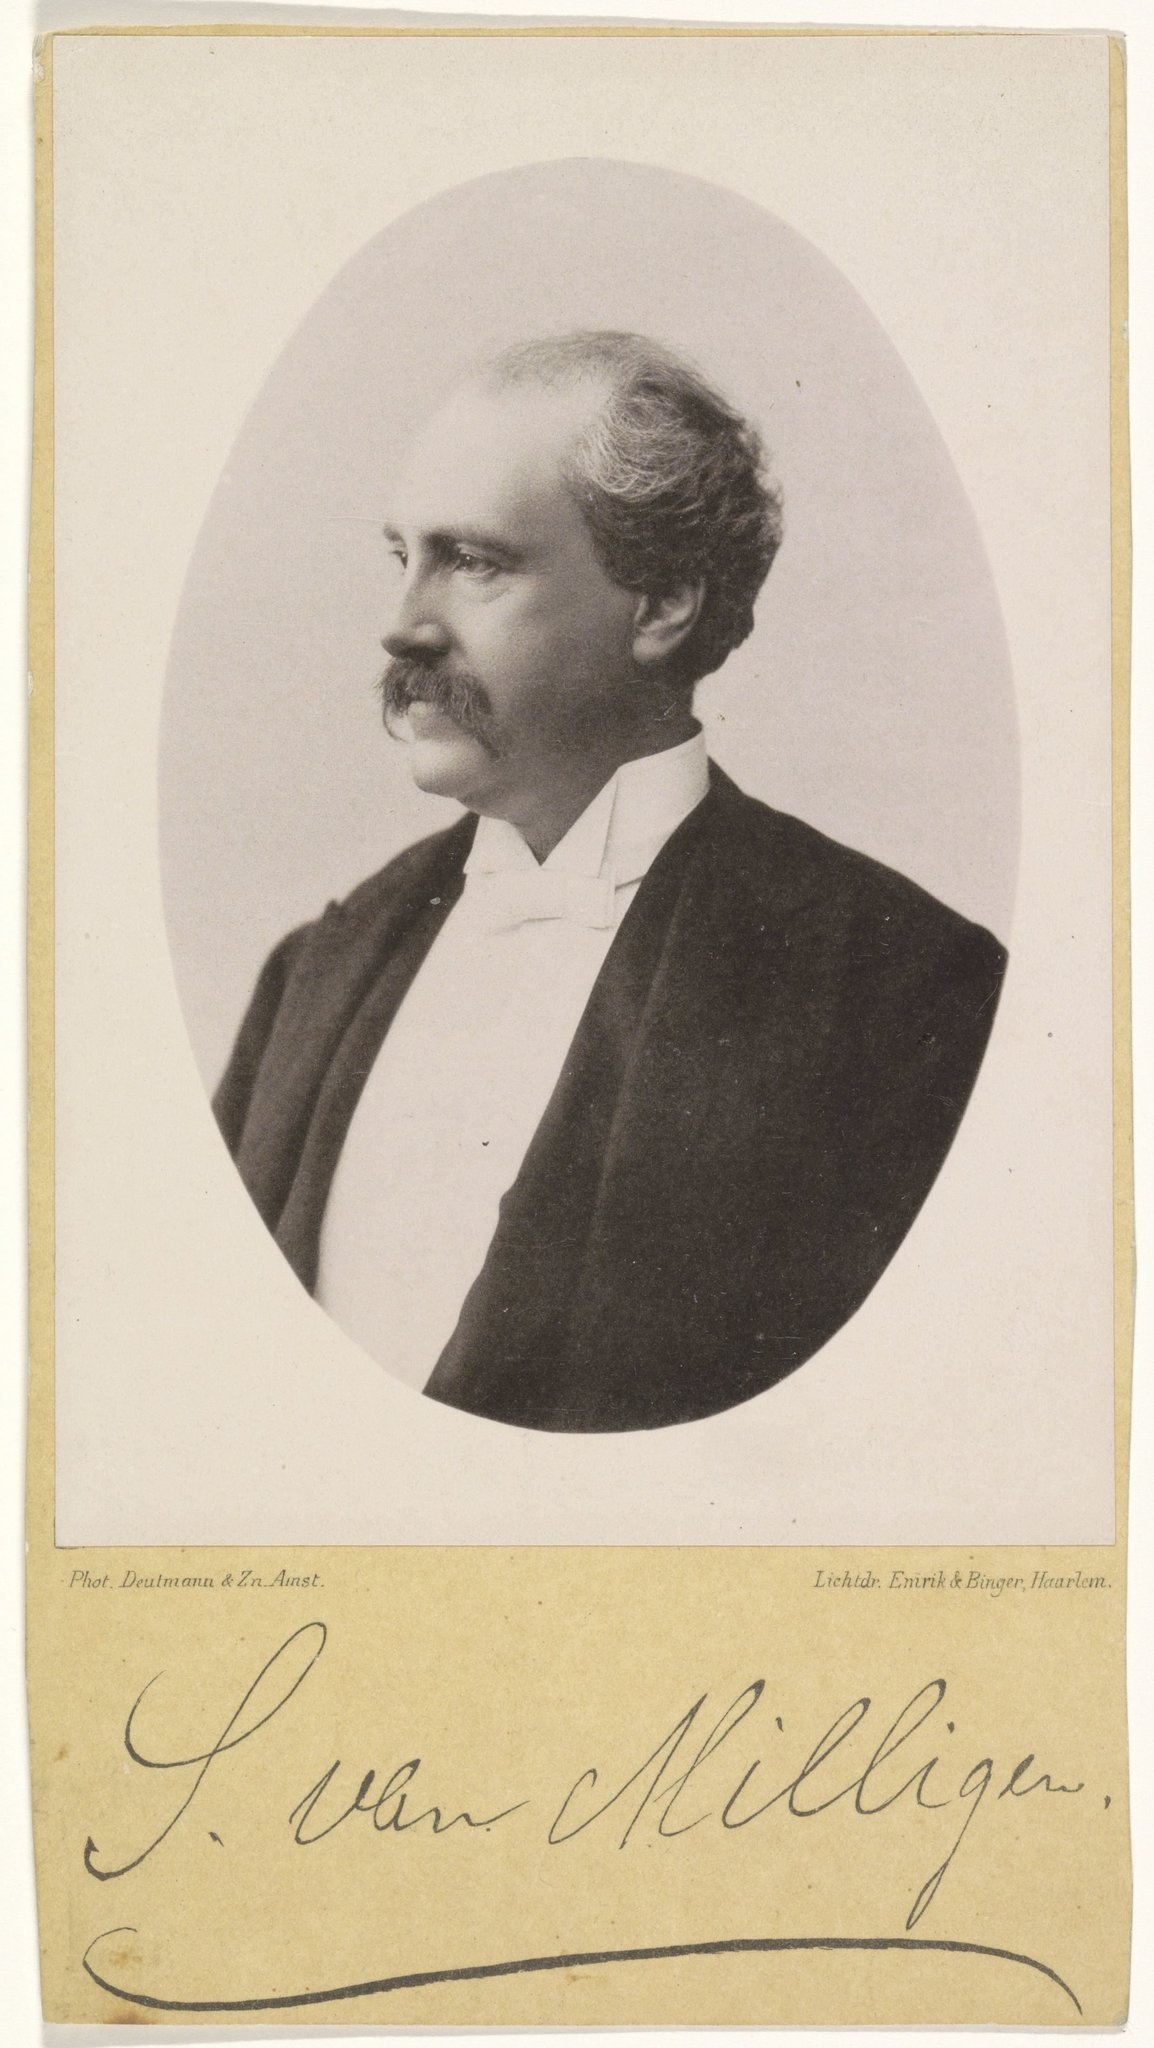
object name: photograph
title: S. van Milligen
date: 1893-1896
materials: cardboard, paper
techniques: photograph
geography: amsterdam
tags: historical persons, netherlands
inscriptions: annotation: ‘phot. Deutmann & Zn / Lichtdr. Emirik & Binger, Haarlem’, annotation: ‘S. van Milligen’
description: H. Viotta, Onze hedendaagsche toonkunstenaars, 1893-1896, Wrsch. plaat uit deze uitgave